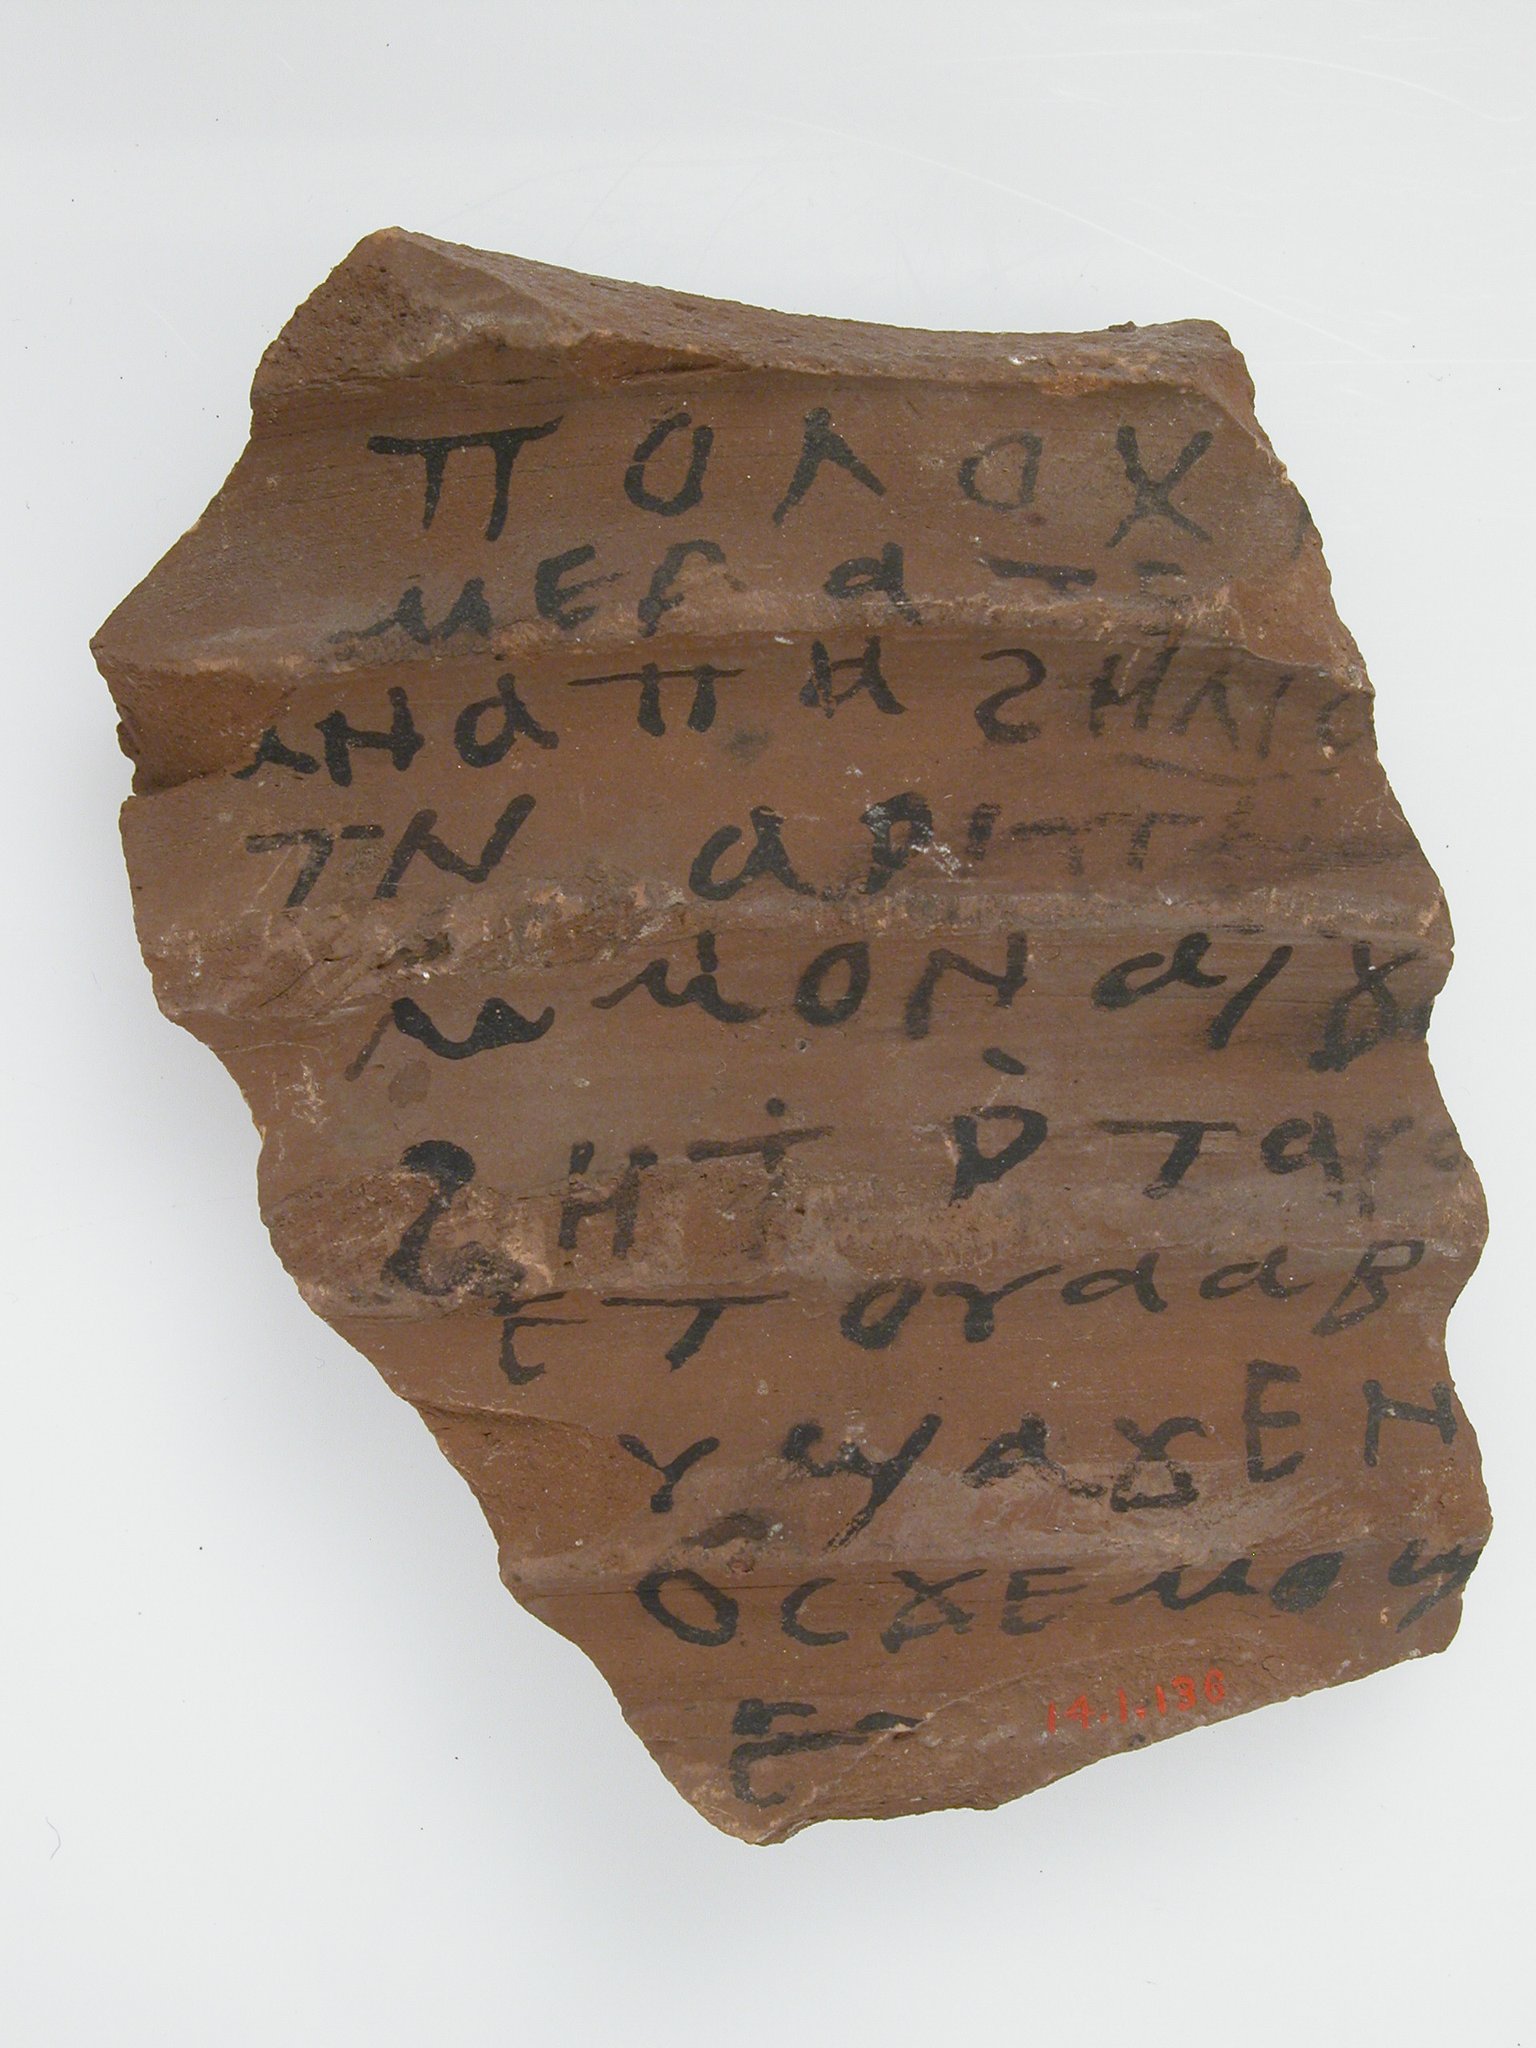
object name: ostrakon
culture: coptic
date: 600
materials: ink, pottery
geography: egypt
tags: coptic,documents